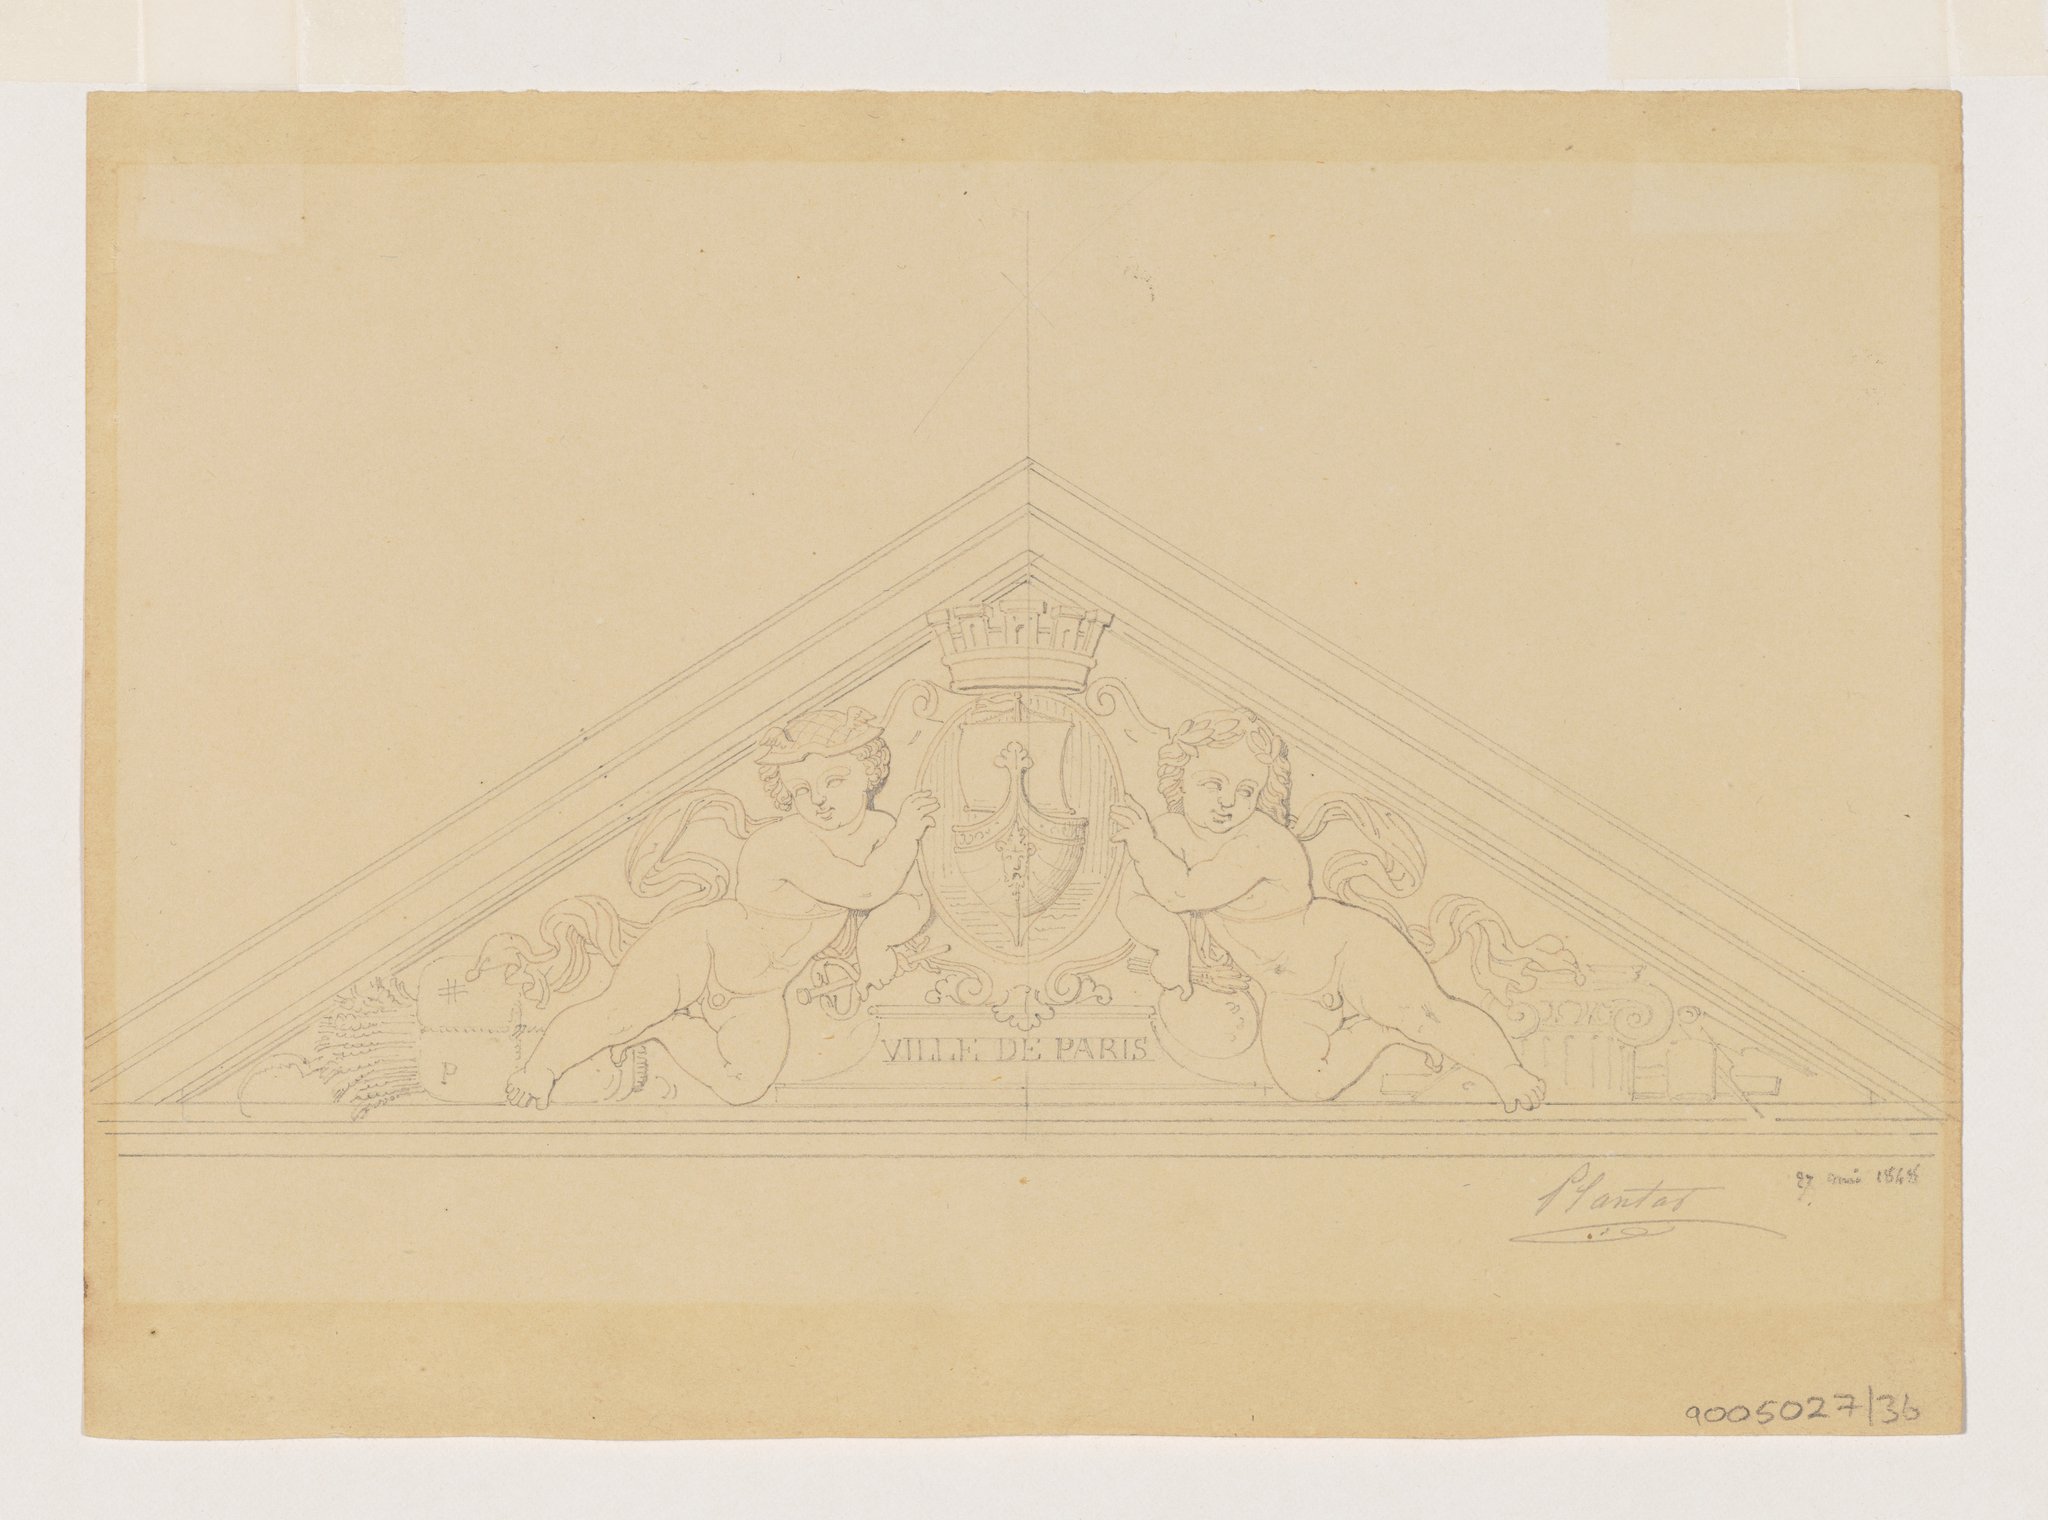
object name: drawing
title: Design for a Pediment inscribed Ville de Paris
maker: jean-baptiste louis plantar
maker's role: artist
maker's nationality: french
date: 1834-1866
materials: graphite, ink, watercolor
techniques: pen